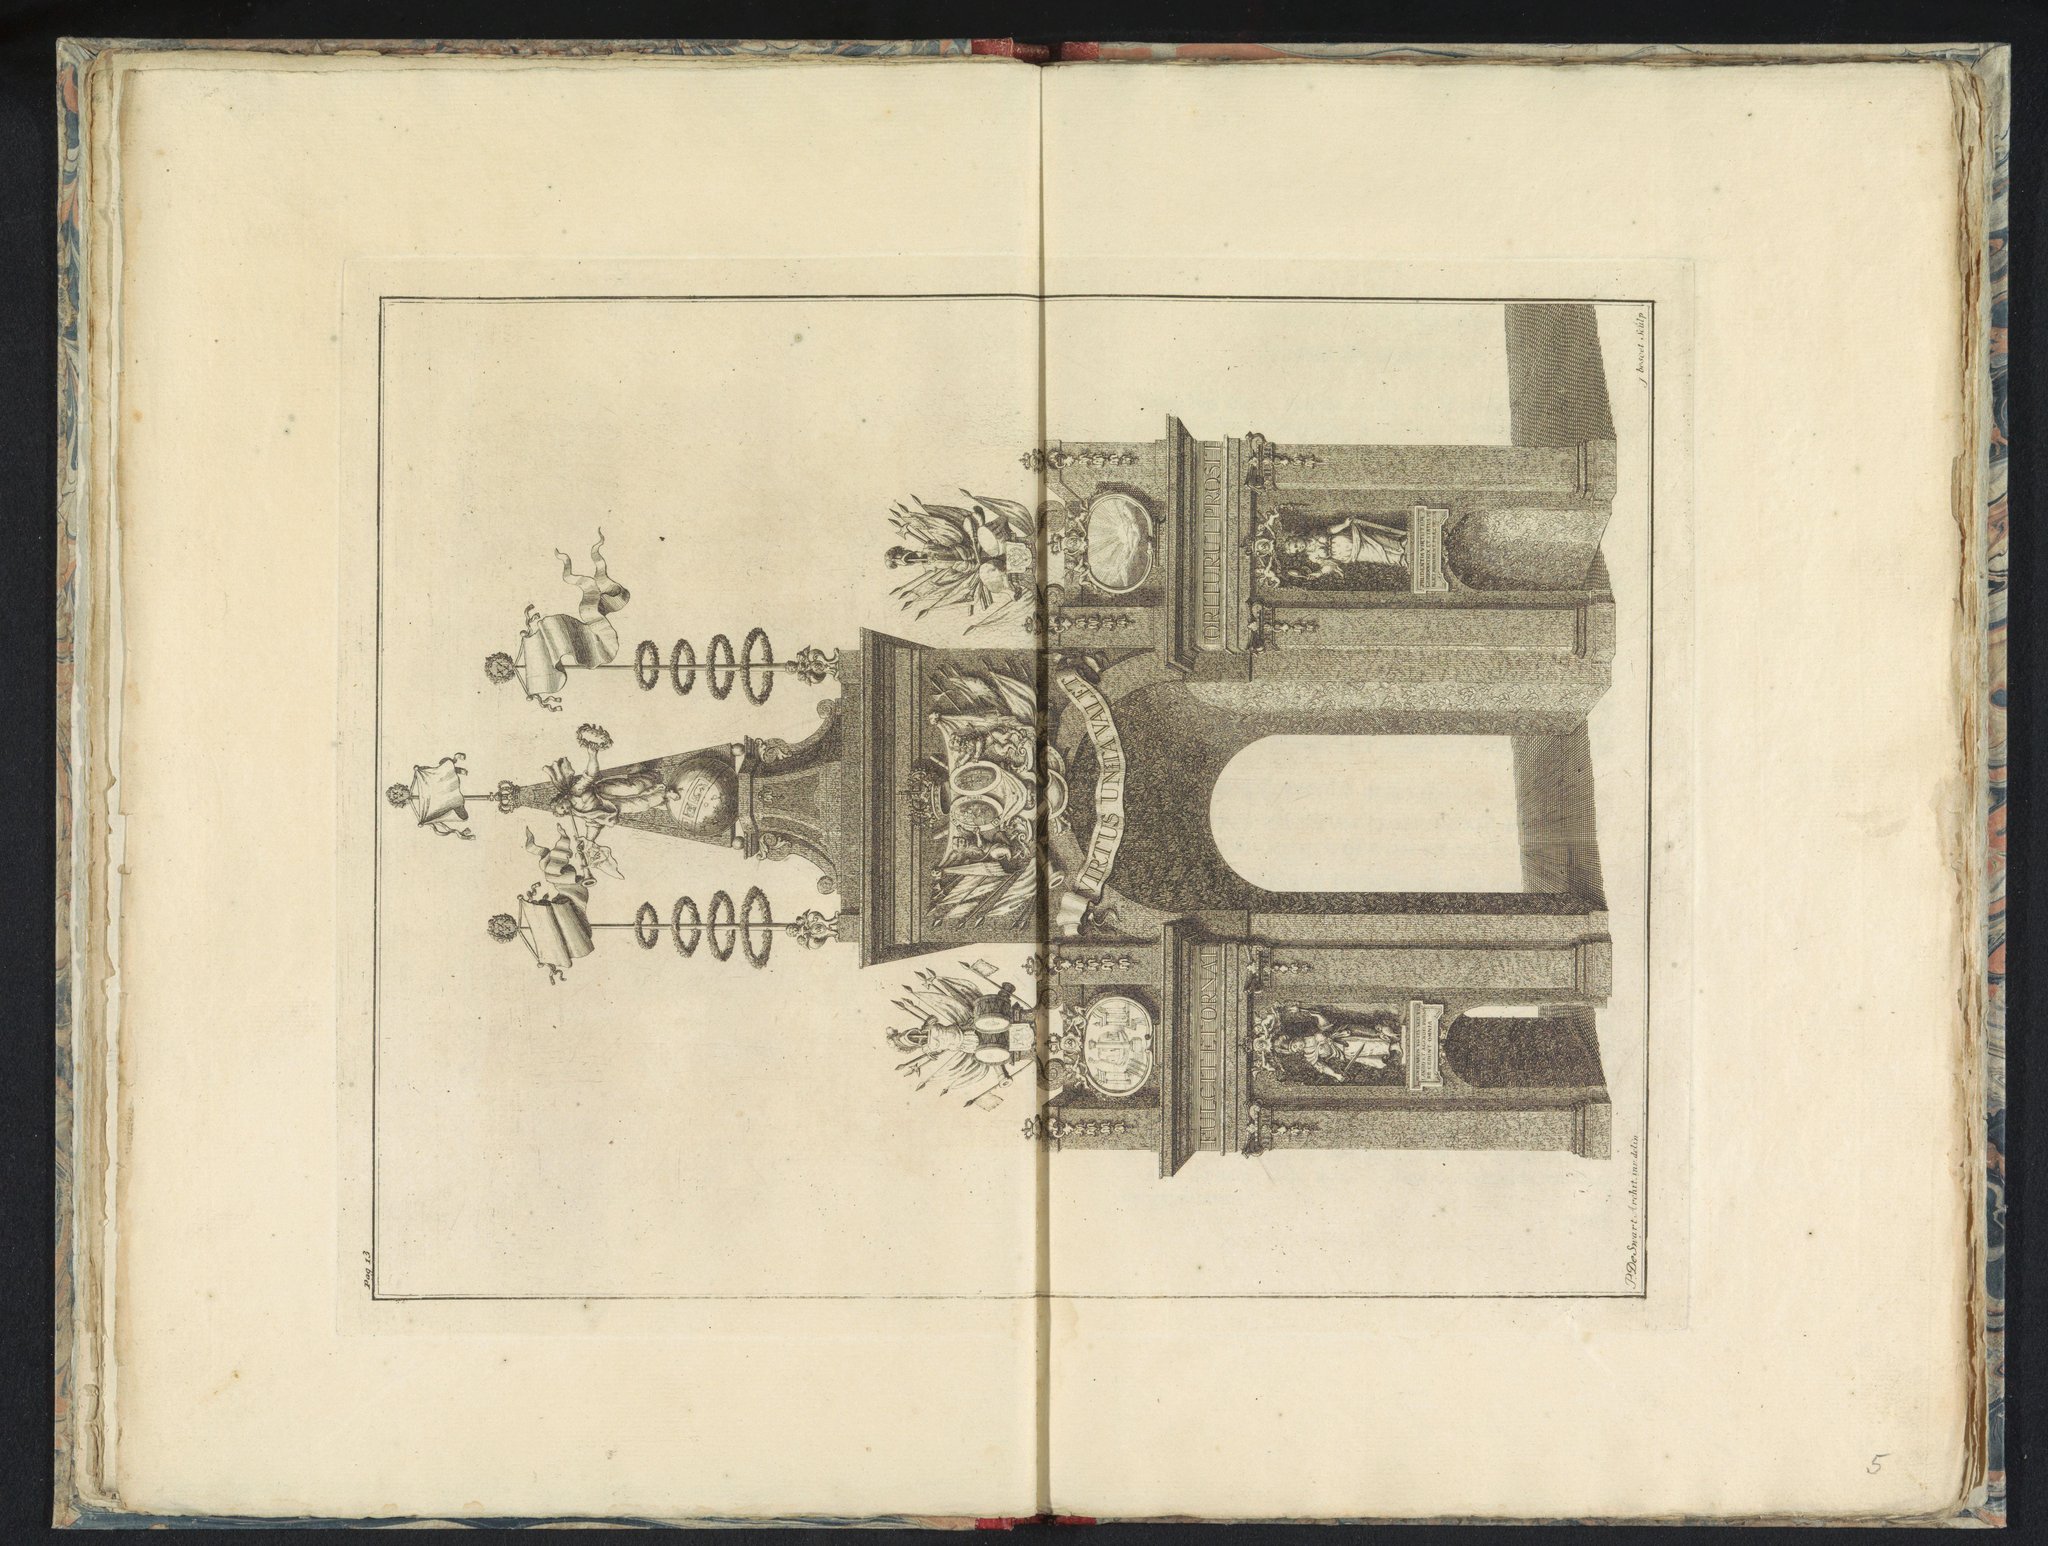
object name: print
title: Ereboog op de Grote Markt bij de intrede van Willem IV te Breda, 1737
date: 1737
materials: paper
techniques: etching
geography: northern netherlands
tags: willem iv (prins van oranje-nassau), anna van hannover, triumphal arch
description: Ereboog opgericht op de Grote Markt bij de intrede van Willem IV en zijn gemalin Anna van Hannover te Breda op 13 september 1737. De boog versierd met standbeelden, wapentrofeeën en wapens. Gemerkt linksboven: Pag 13.